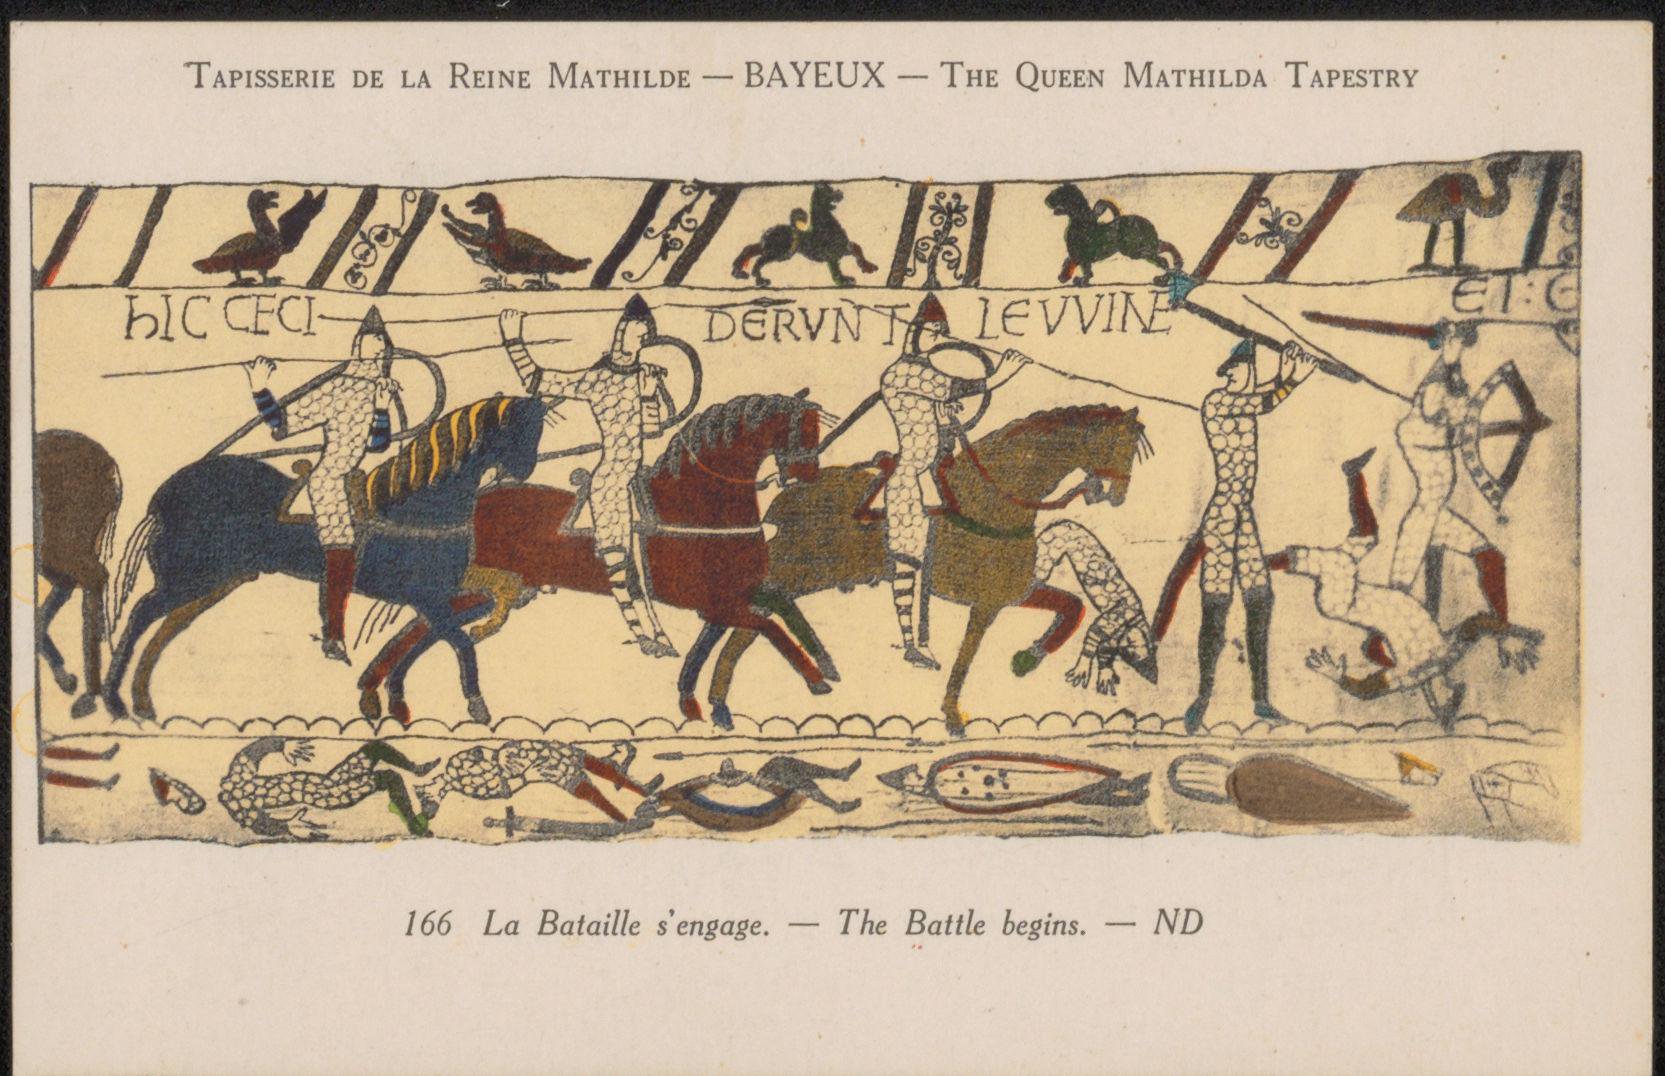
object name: ansichtkaart, prentbriefkaart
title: Prentbriefkaart aan Ab Bogtman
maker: richard nicolaüs roland holst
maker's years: 1868-1938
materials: cardboard, ink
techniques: photograph, pen, writing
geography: paris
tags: ab bogtman, photography, cinematography